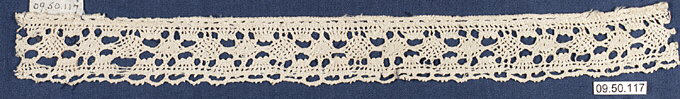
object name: strip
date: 1701-1800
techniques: lace